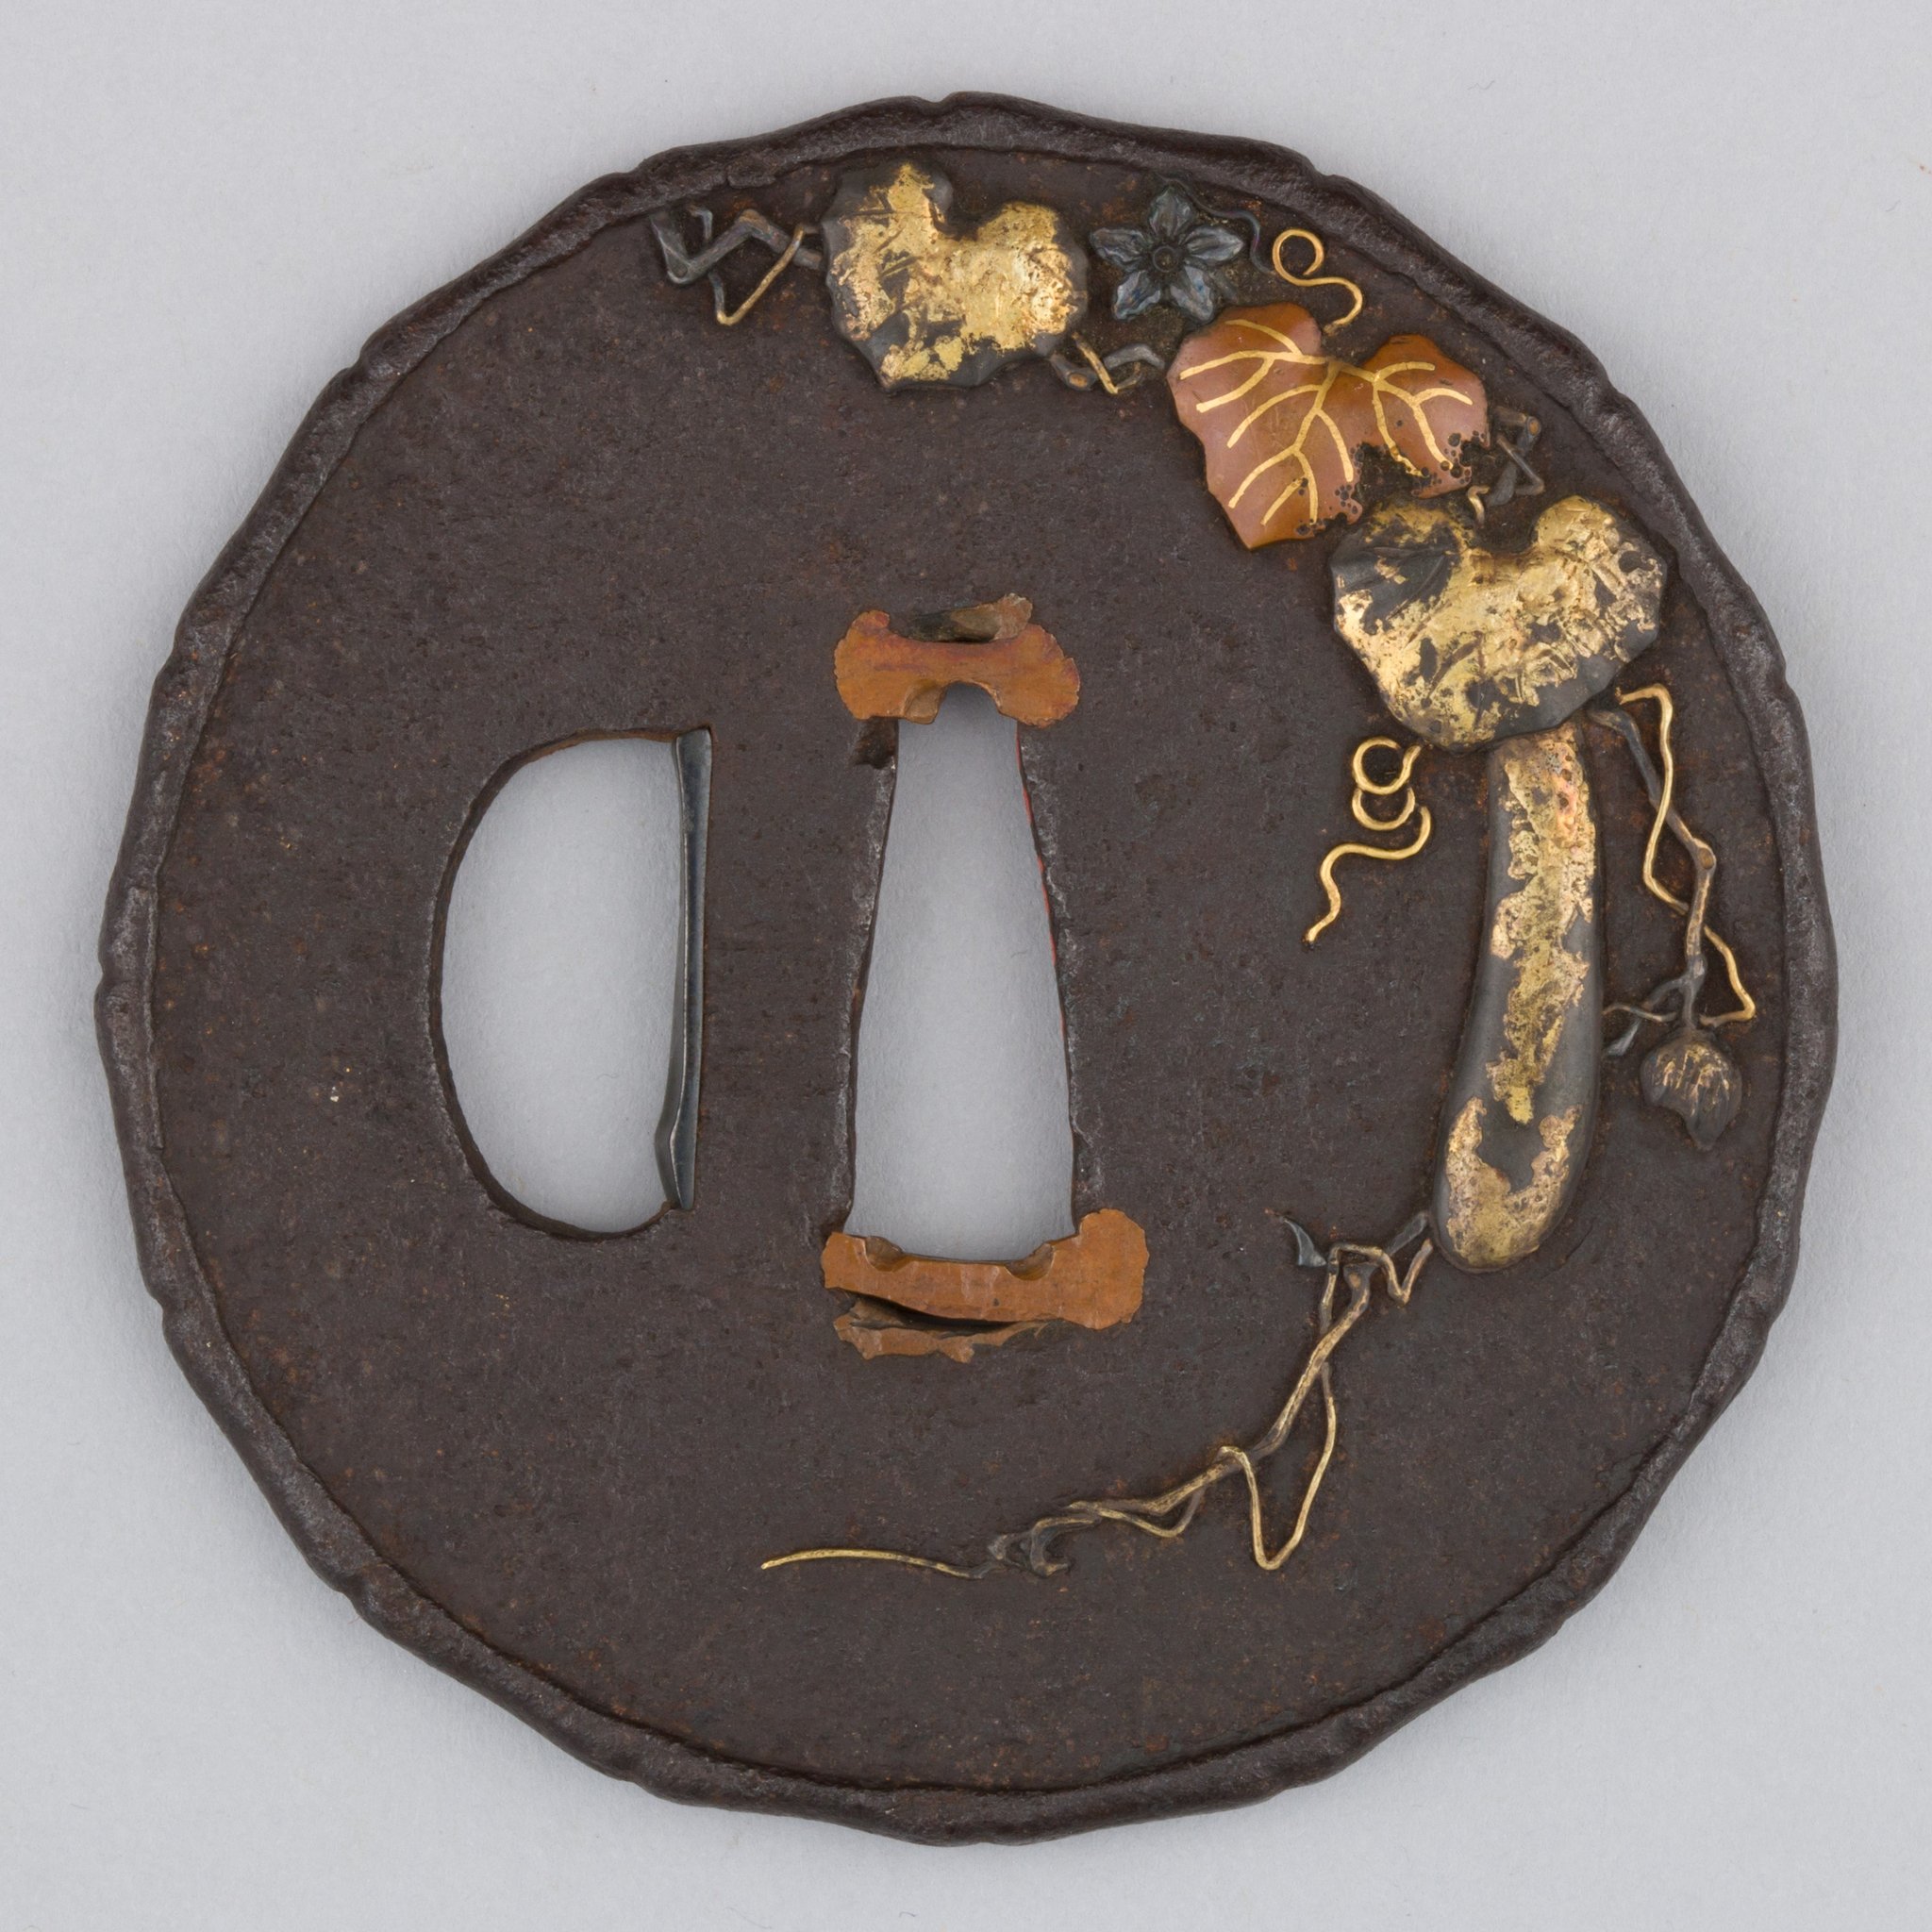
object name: sword guard tsuba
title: Sword Guard (Tsuba)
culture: japanese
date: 1615-1868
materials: copper, silver alloy, gold, iron, silver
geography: japan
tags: gourds